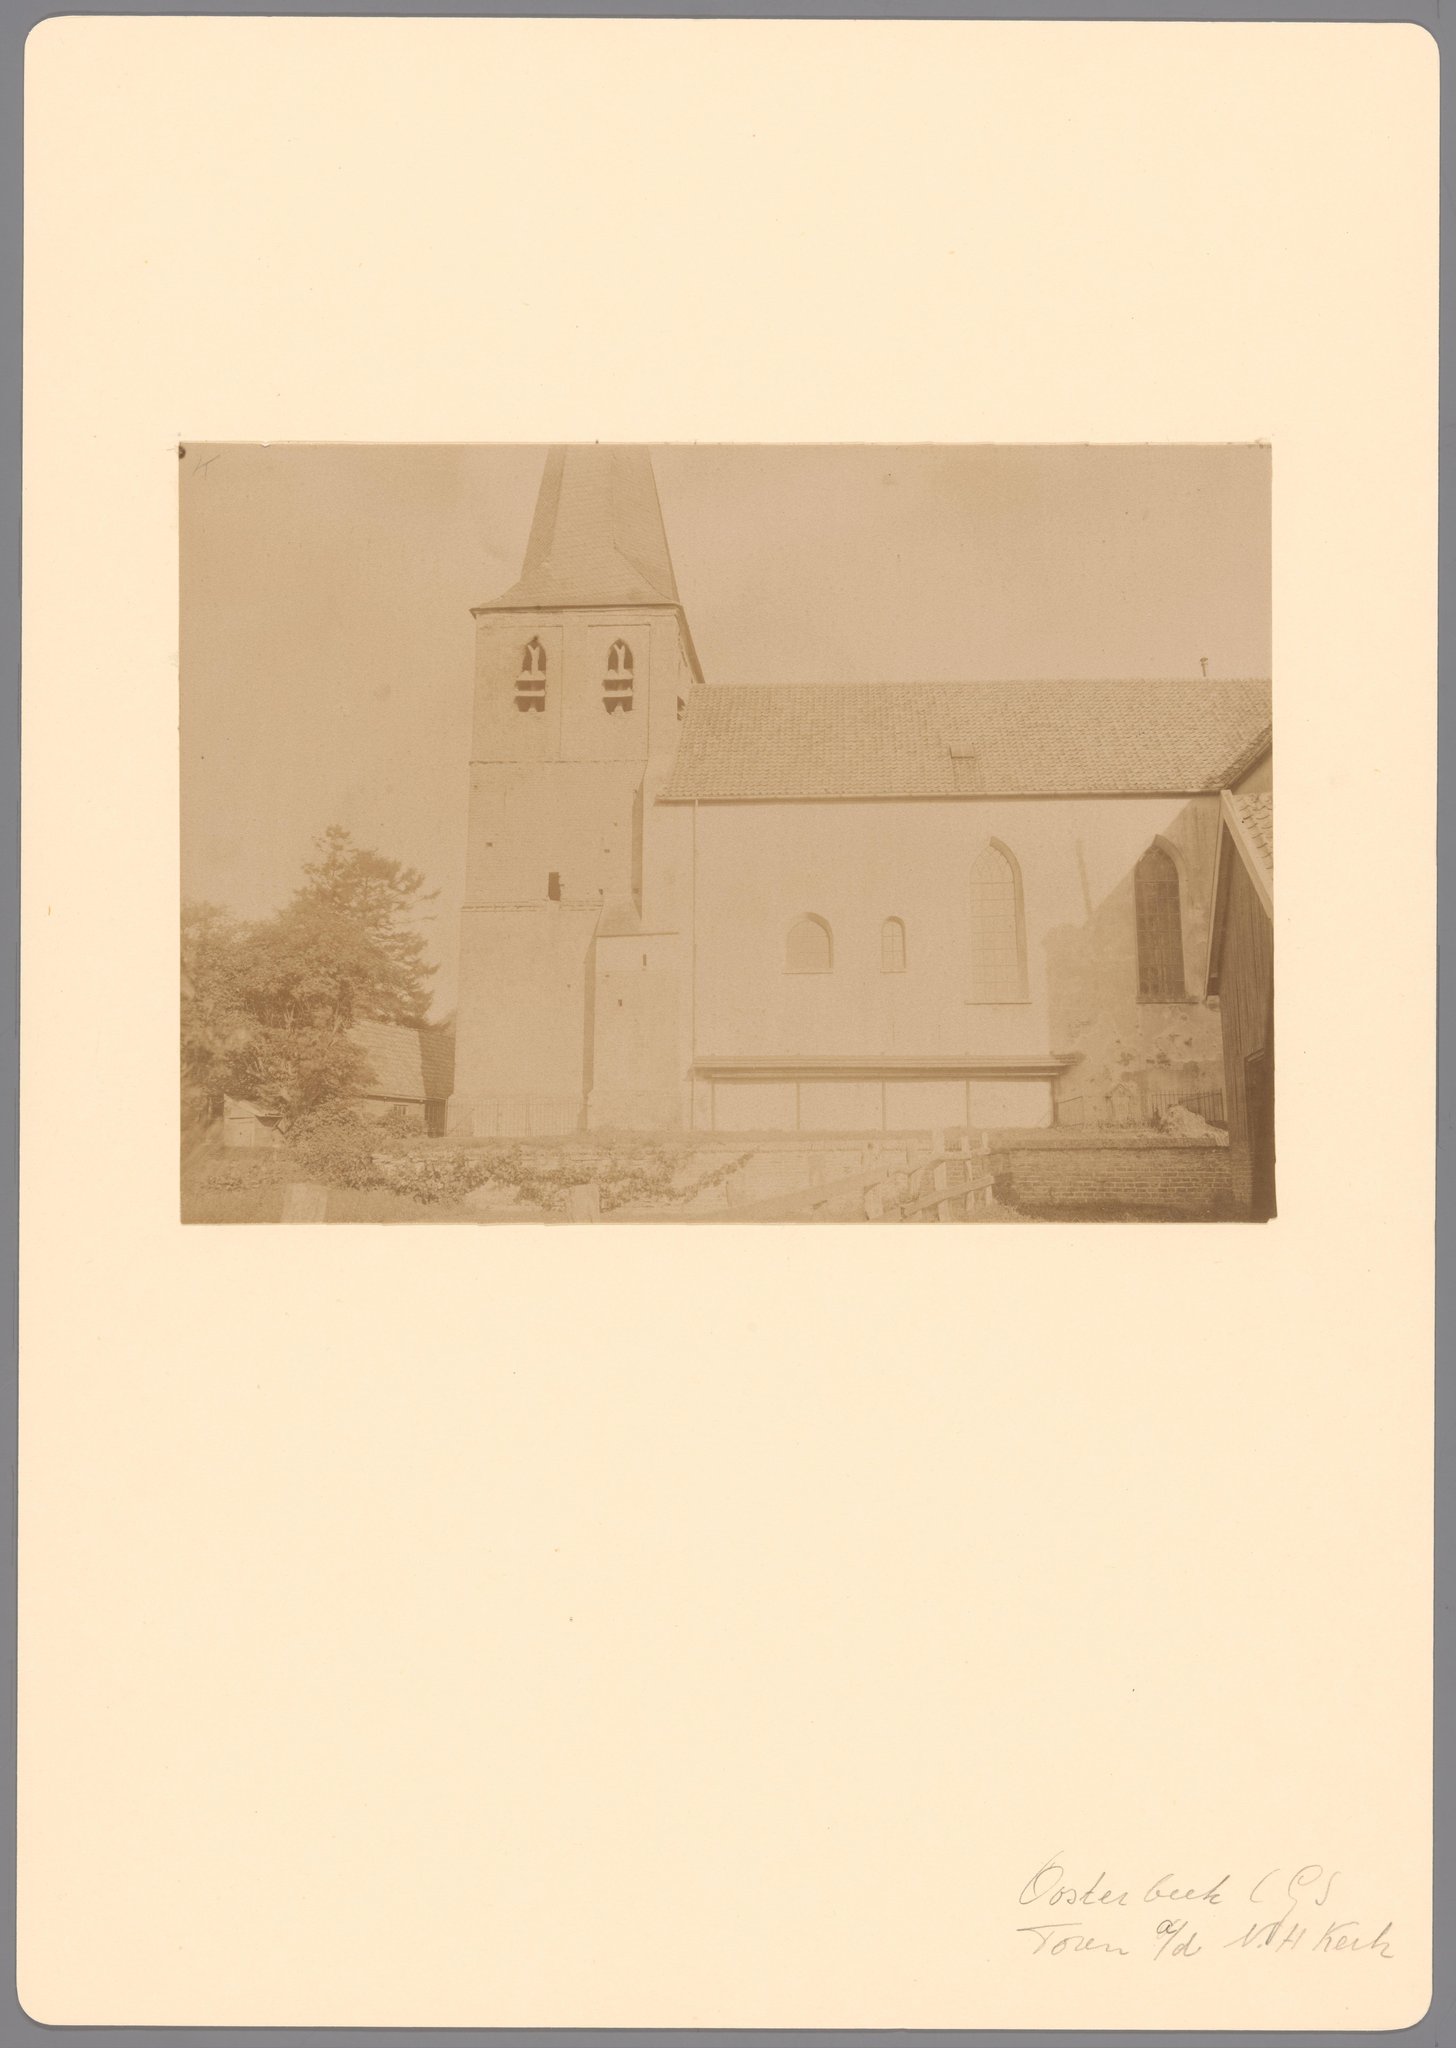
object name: photograph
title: Toren van de Oude Kerk te Oosterbeek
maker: anoniem (monumentenzorg)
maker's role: fotograaf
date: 1890-1920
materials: cardboard, photographic support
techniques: albumen print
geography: oosterbeek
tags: parts of church exterior and annexes: tower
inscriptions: annotation: ‘K/ Oosterbeek (G.)/ Toren a/d N.H. Kerk’